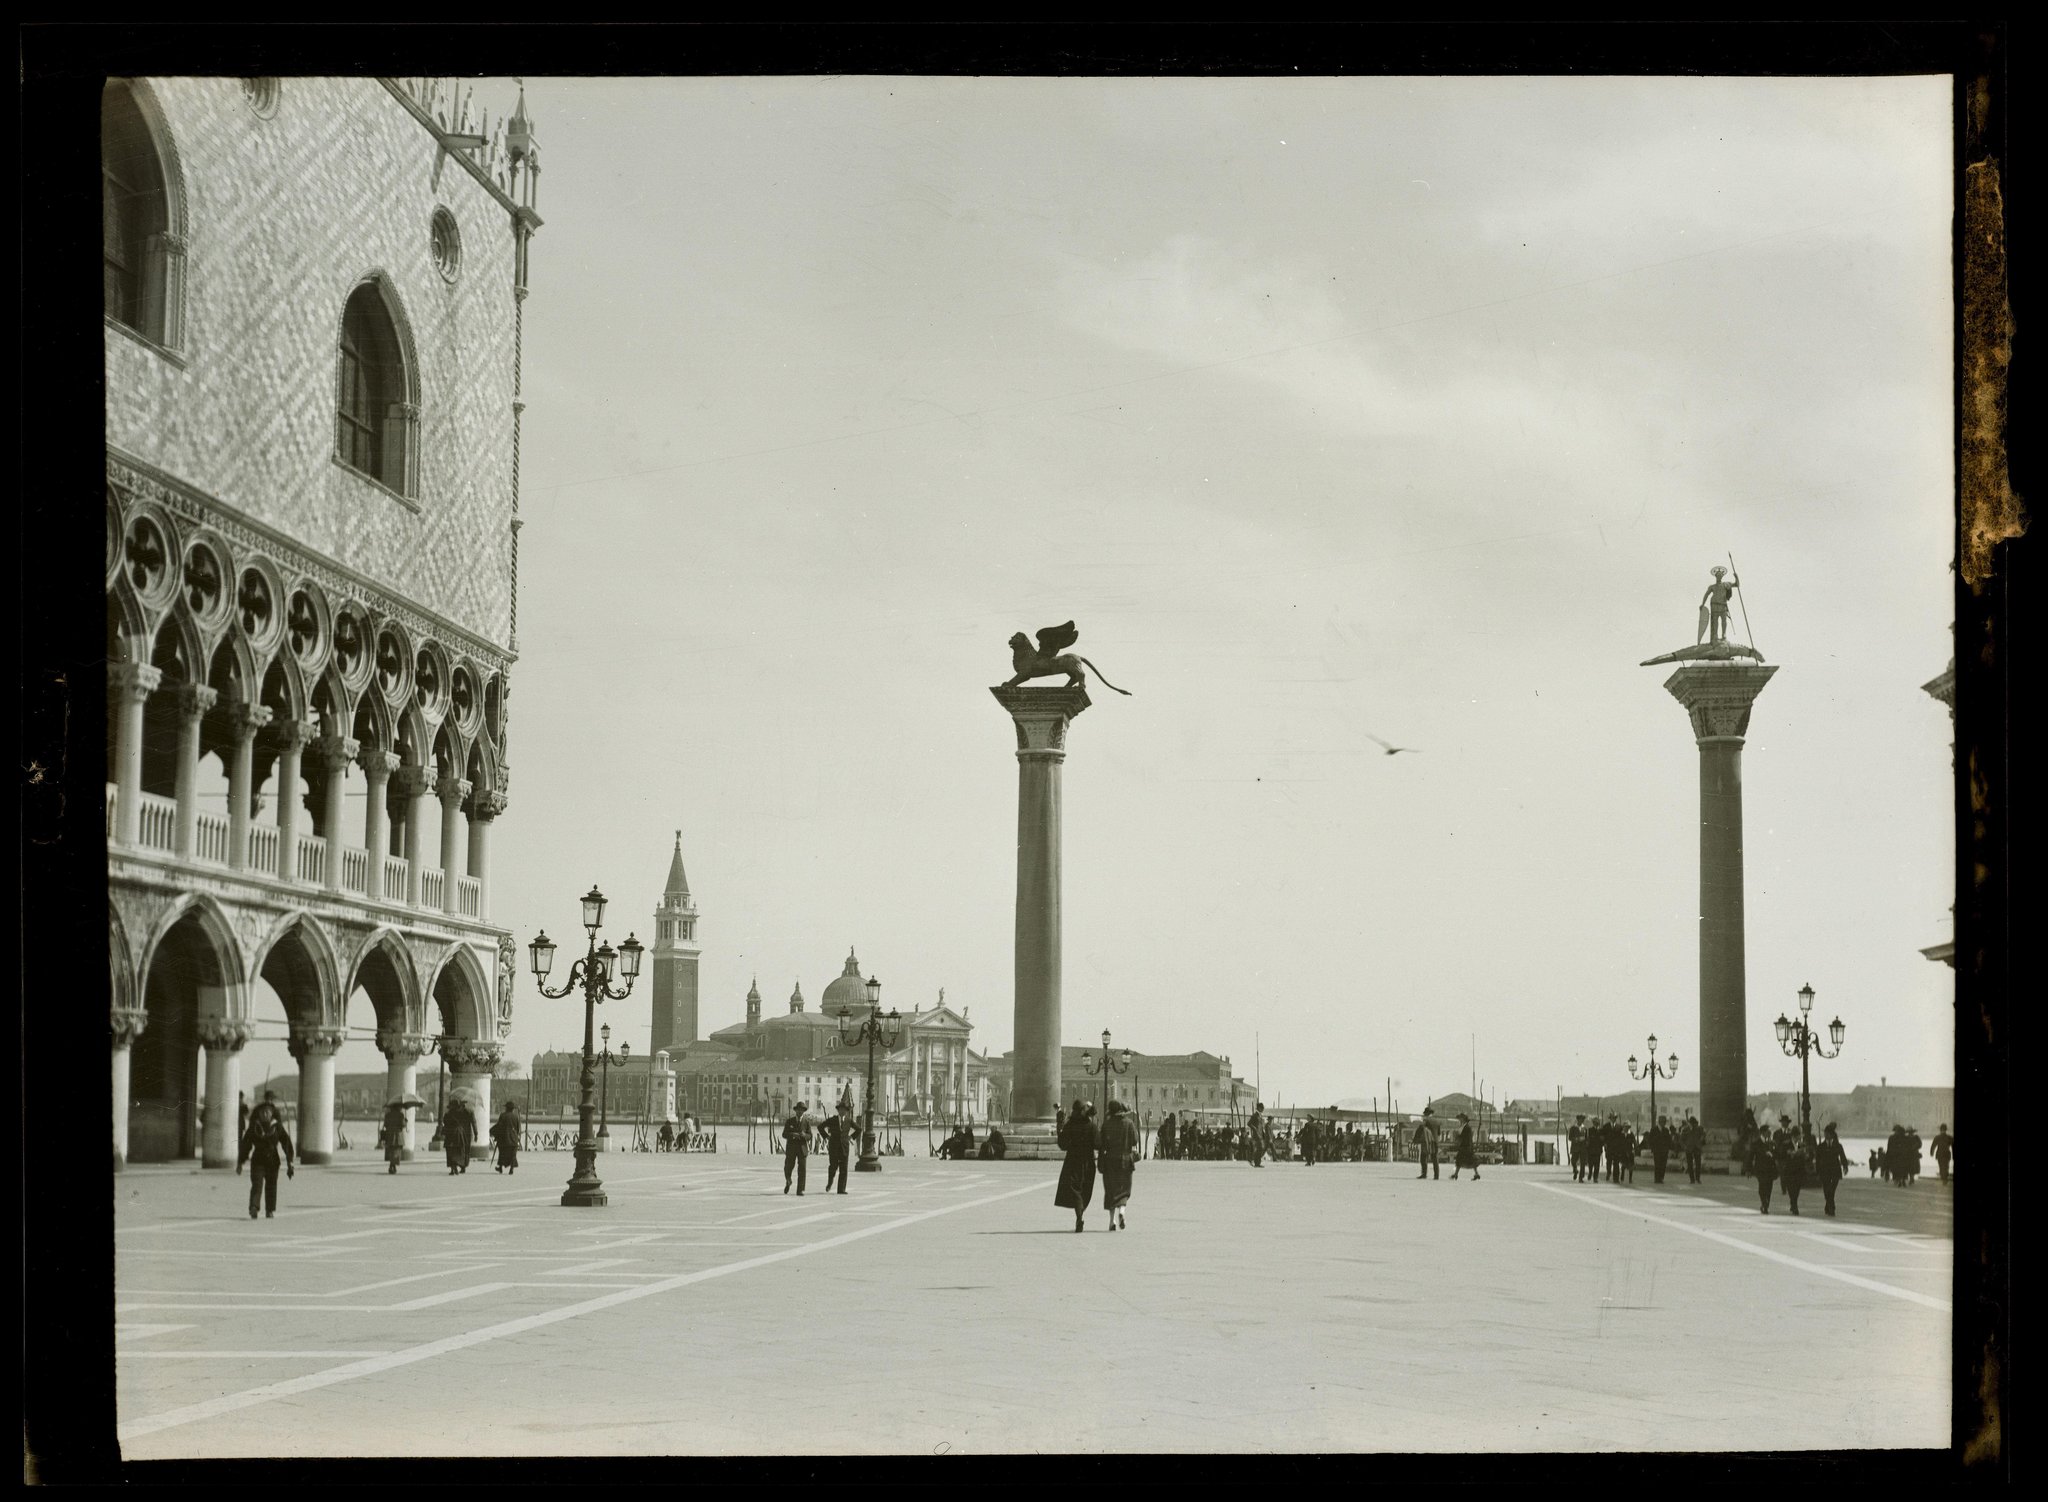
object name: photograph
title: Filmnegatief met opname van Venetië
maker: Anonymous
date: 1907-1935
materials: film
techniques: gelatin silver negative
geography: venice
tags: venice